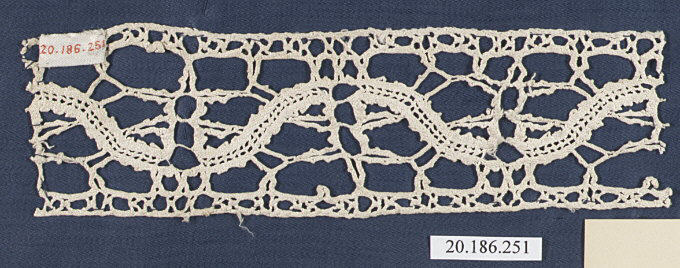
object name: insertion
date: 1601-1700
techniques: lace